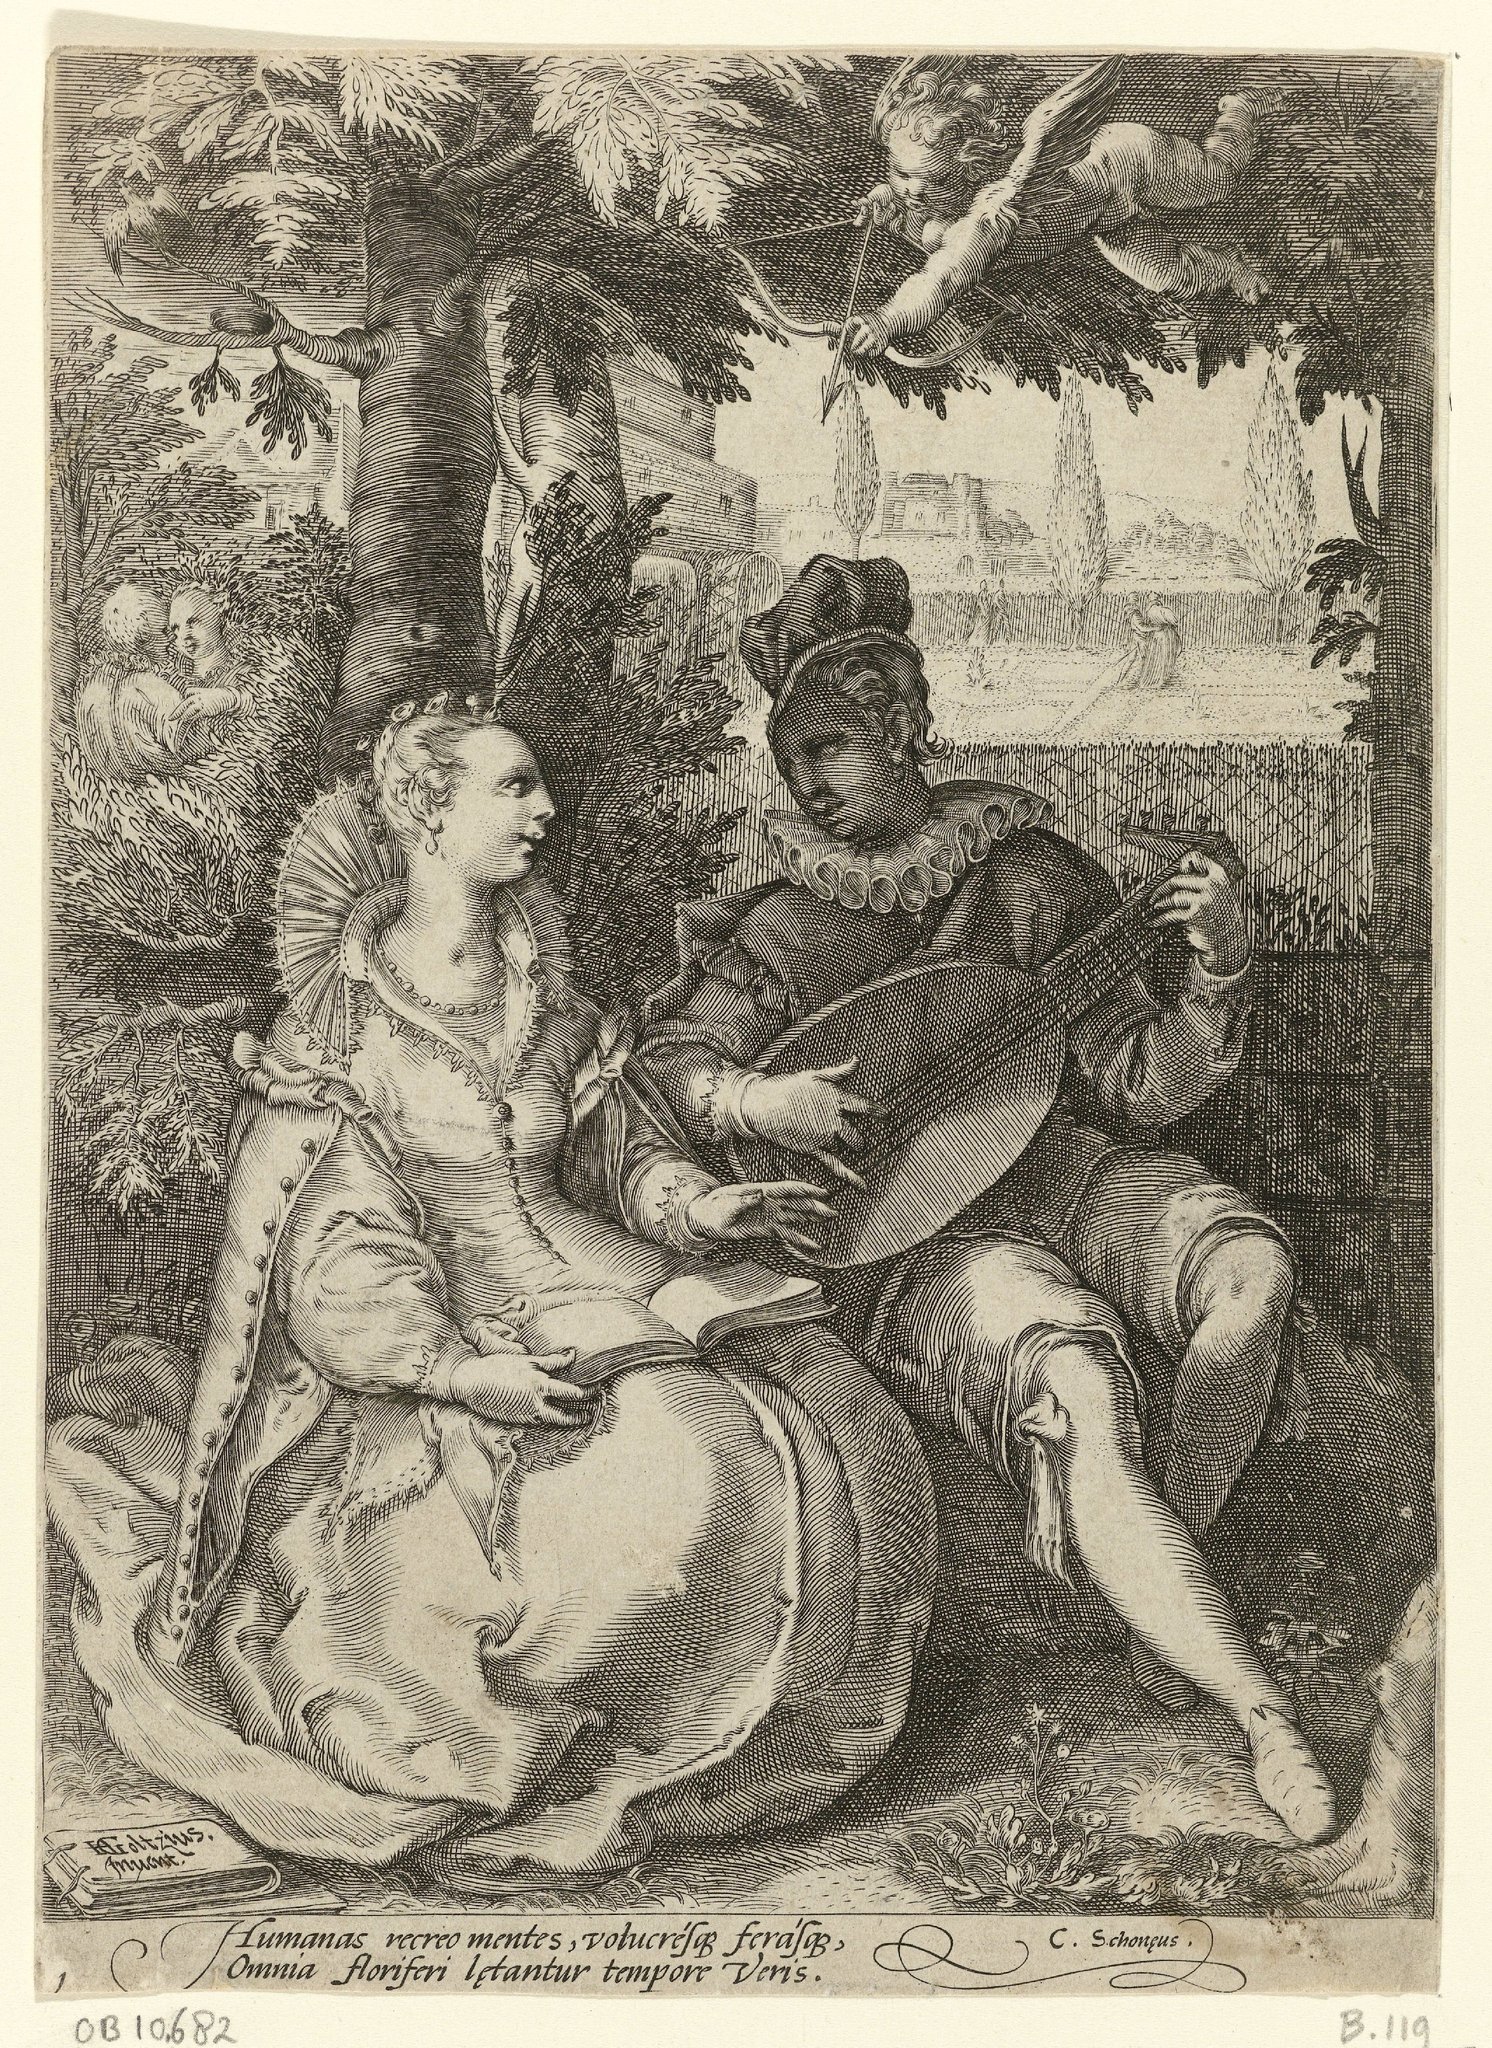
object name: print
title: Vier seizoenen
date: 1590-1600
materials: paper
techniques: engraving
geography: northern netherlands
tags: instrumental and vocal music together, spring ~ human activities (the four seasons of the year), couple of lovers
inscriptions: collector's mark: Lugt 240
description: Een man en een vrouw maken samen muziek in een tuin. De man bespeelt een luit en de vrouw zingt. Op haar schoot ligt een opengeslagen boek. Amor staat op het punt om een pijl in hun richting te schieten. Links omhelst een paar elkaar in het struikgewas. In de verte wandelen enkele paren. Onder de voorstelling een tweeregelige, Latijnse tekst met een toelichting op de scène.